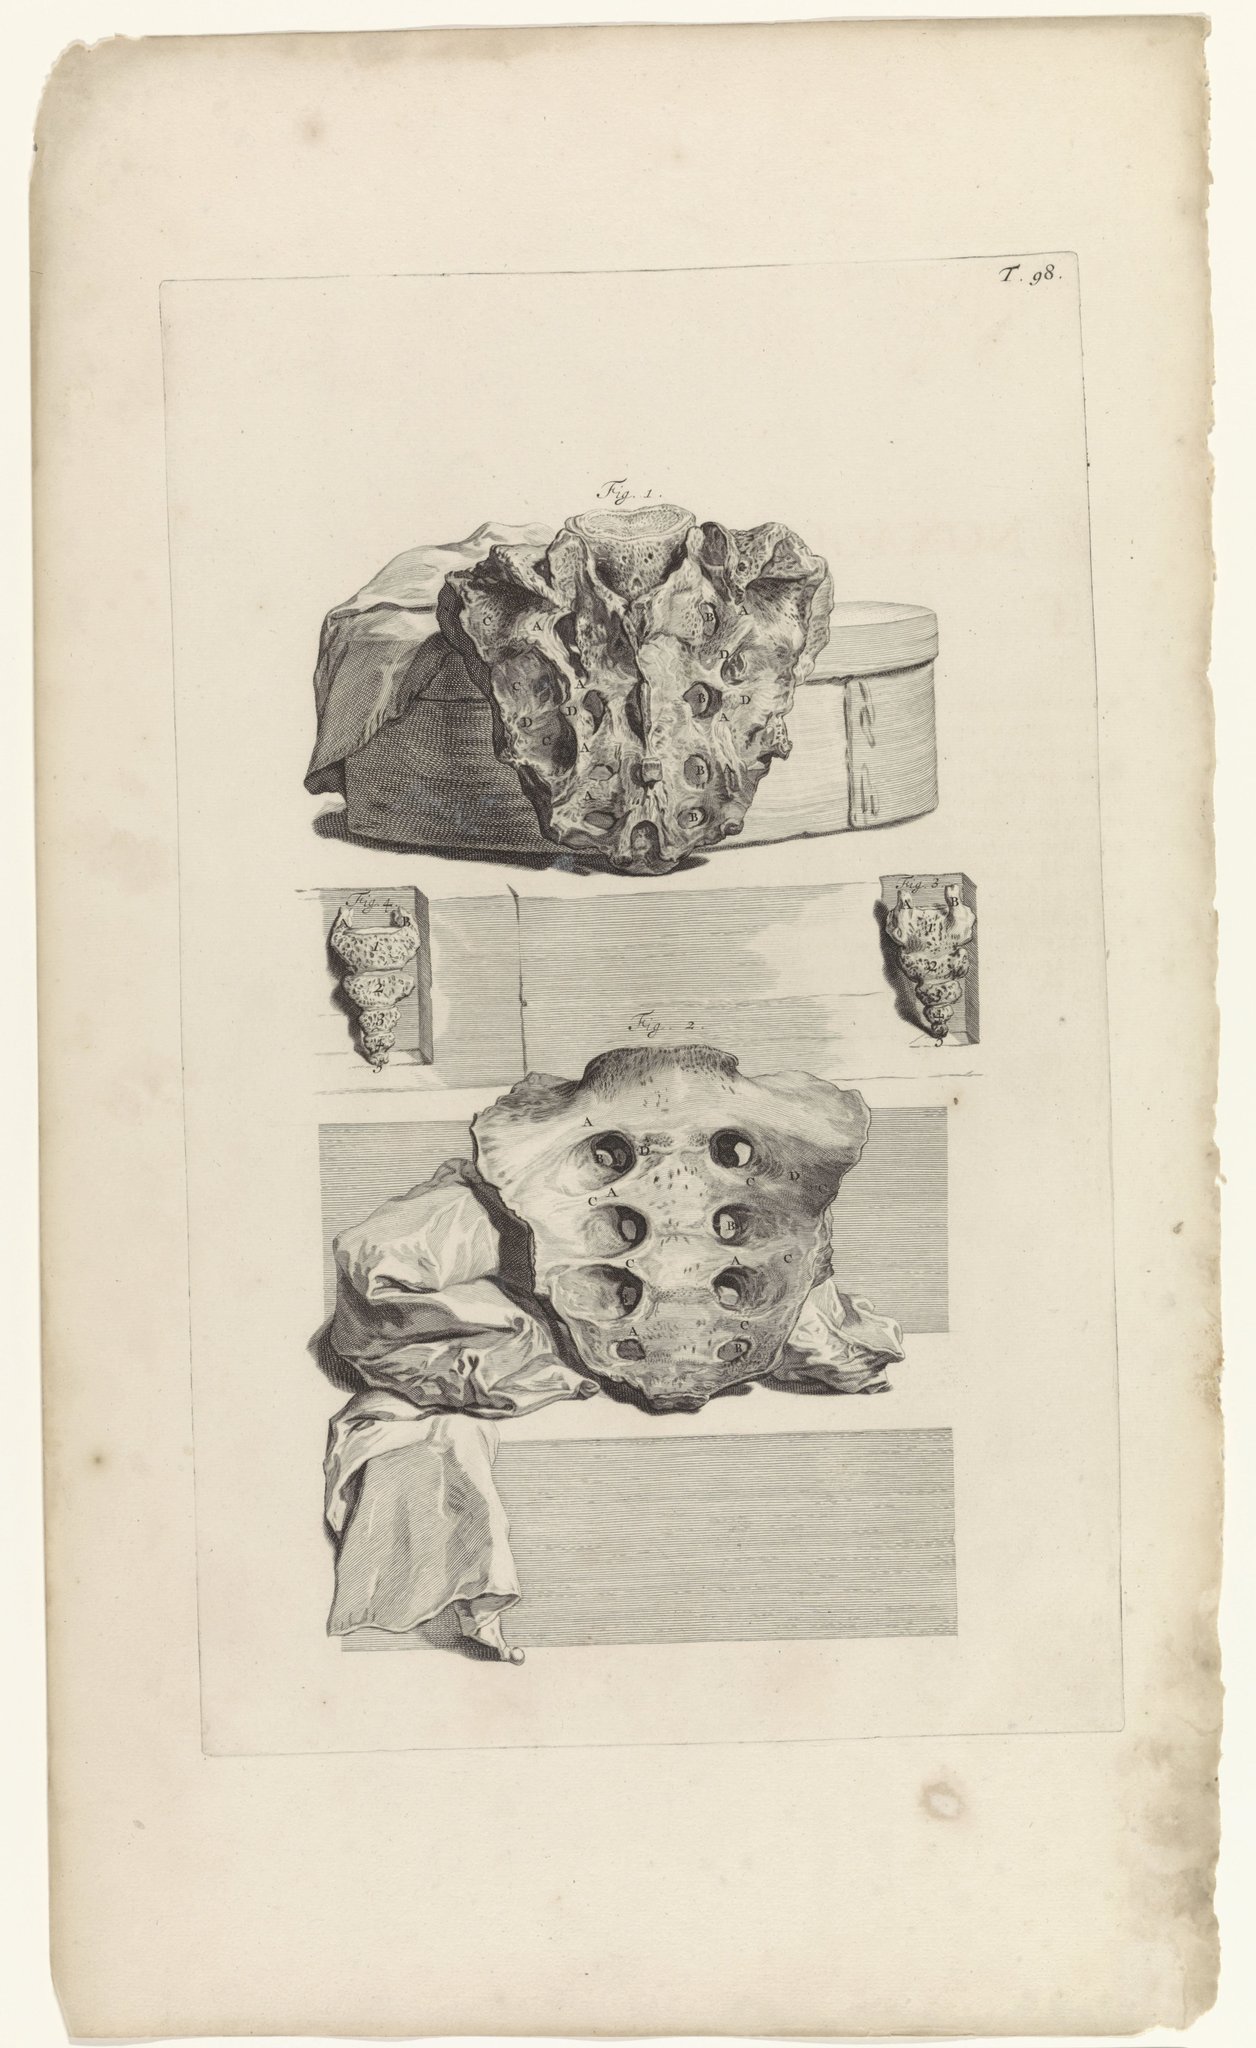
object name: print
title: Anatomische studie van het heilig been en het staartbeen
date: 1685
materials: paper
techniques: engraving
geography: amsterdam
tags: pelvis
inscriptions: collector's mark: Lugt 2228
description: Boekillustratie voor Bidloo, Godefridus. Anatomia humani corporis centum & quinque tabulis, per art. G. de Lairesse ad vivum delineatis, de monstrata, veterum recentiorumque inventis explicata plurimisque, hactenus non detectis, illustrata. Amsterdam: Weduwe Joannes van Someren, Hendrick Boom en erven Dirk Boom, 1685.